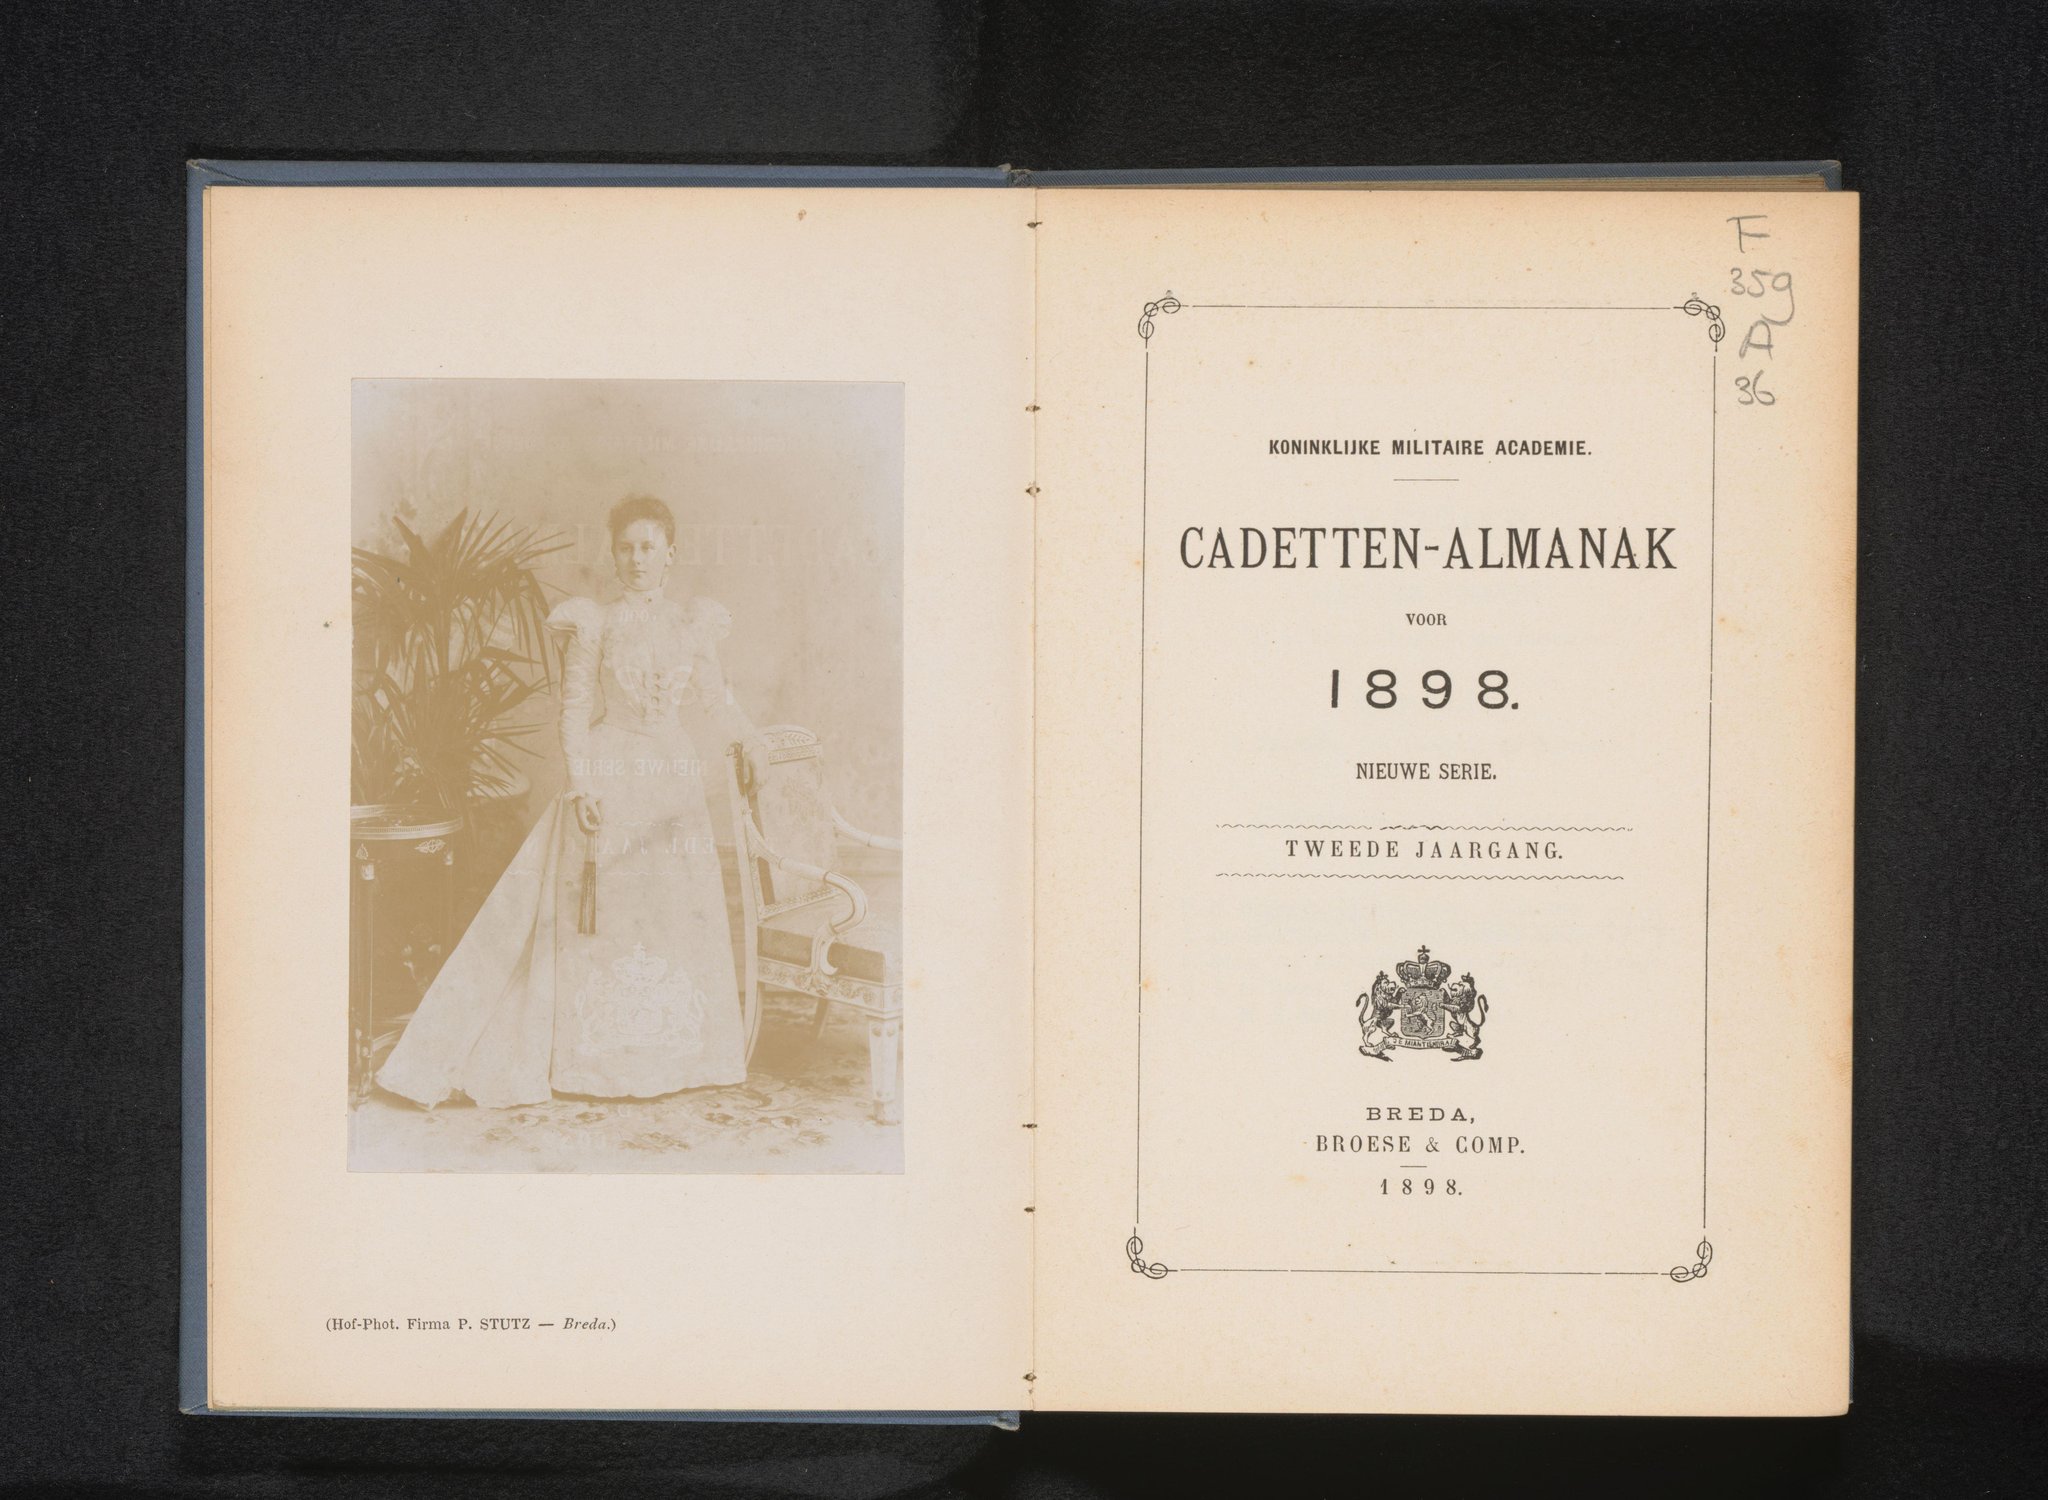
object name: book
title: Cadetten-almanak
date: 1898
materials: cardboard, linen, paper, photographic support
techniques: printing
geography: breda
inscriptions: number: ‘2,=’